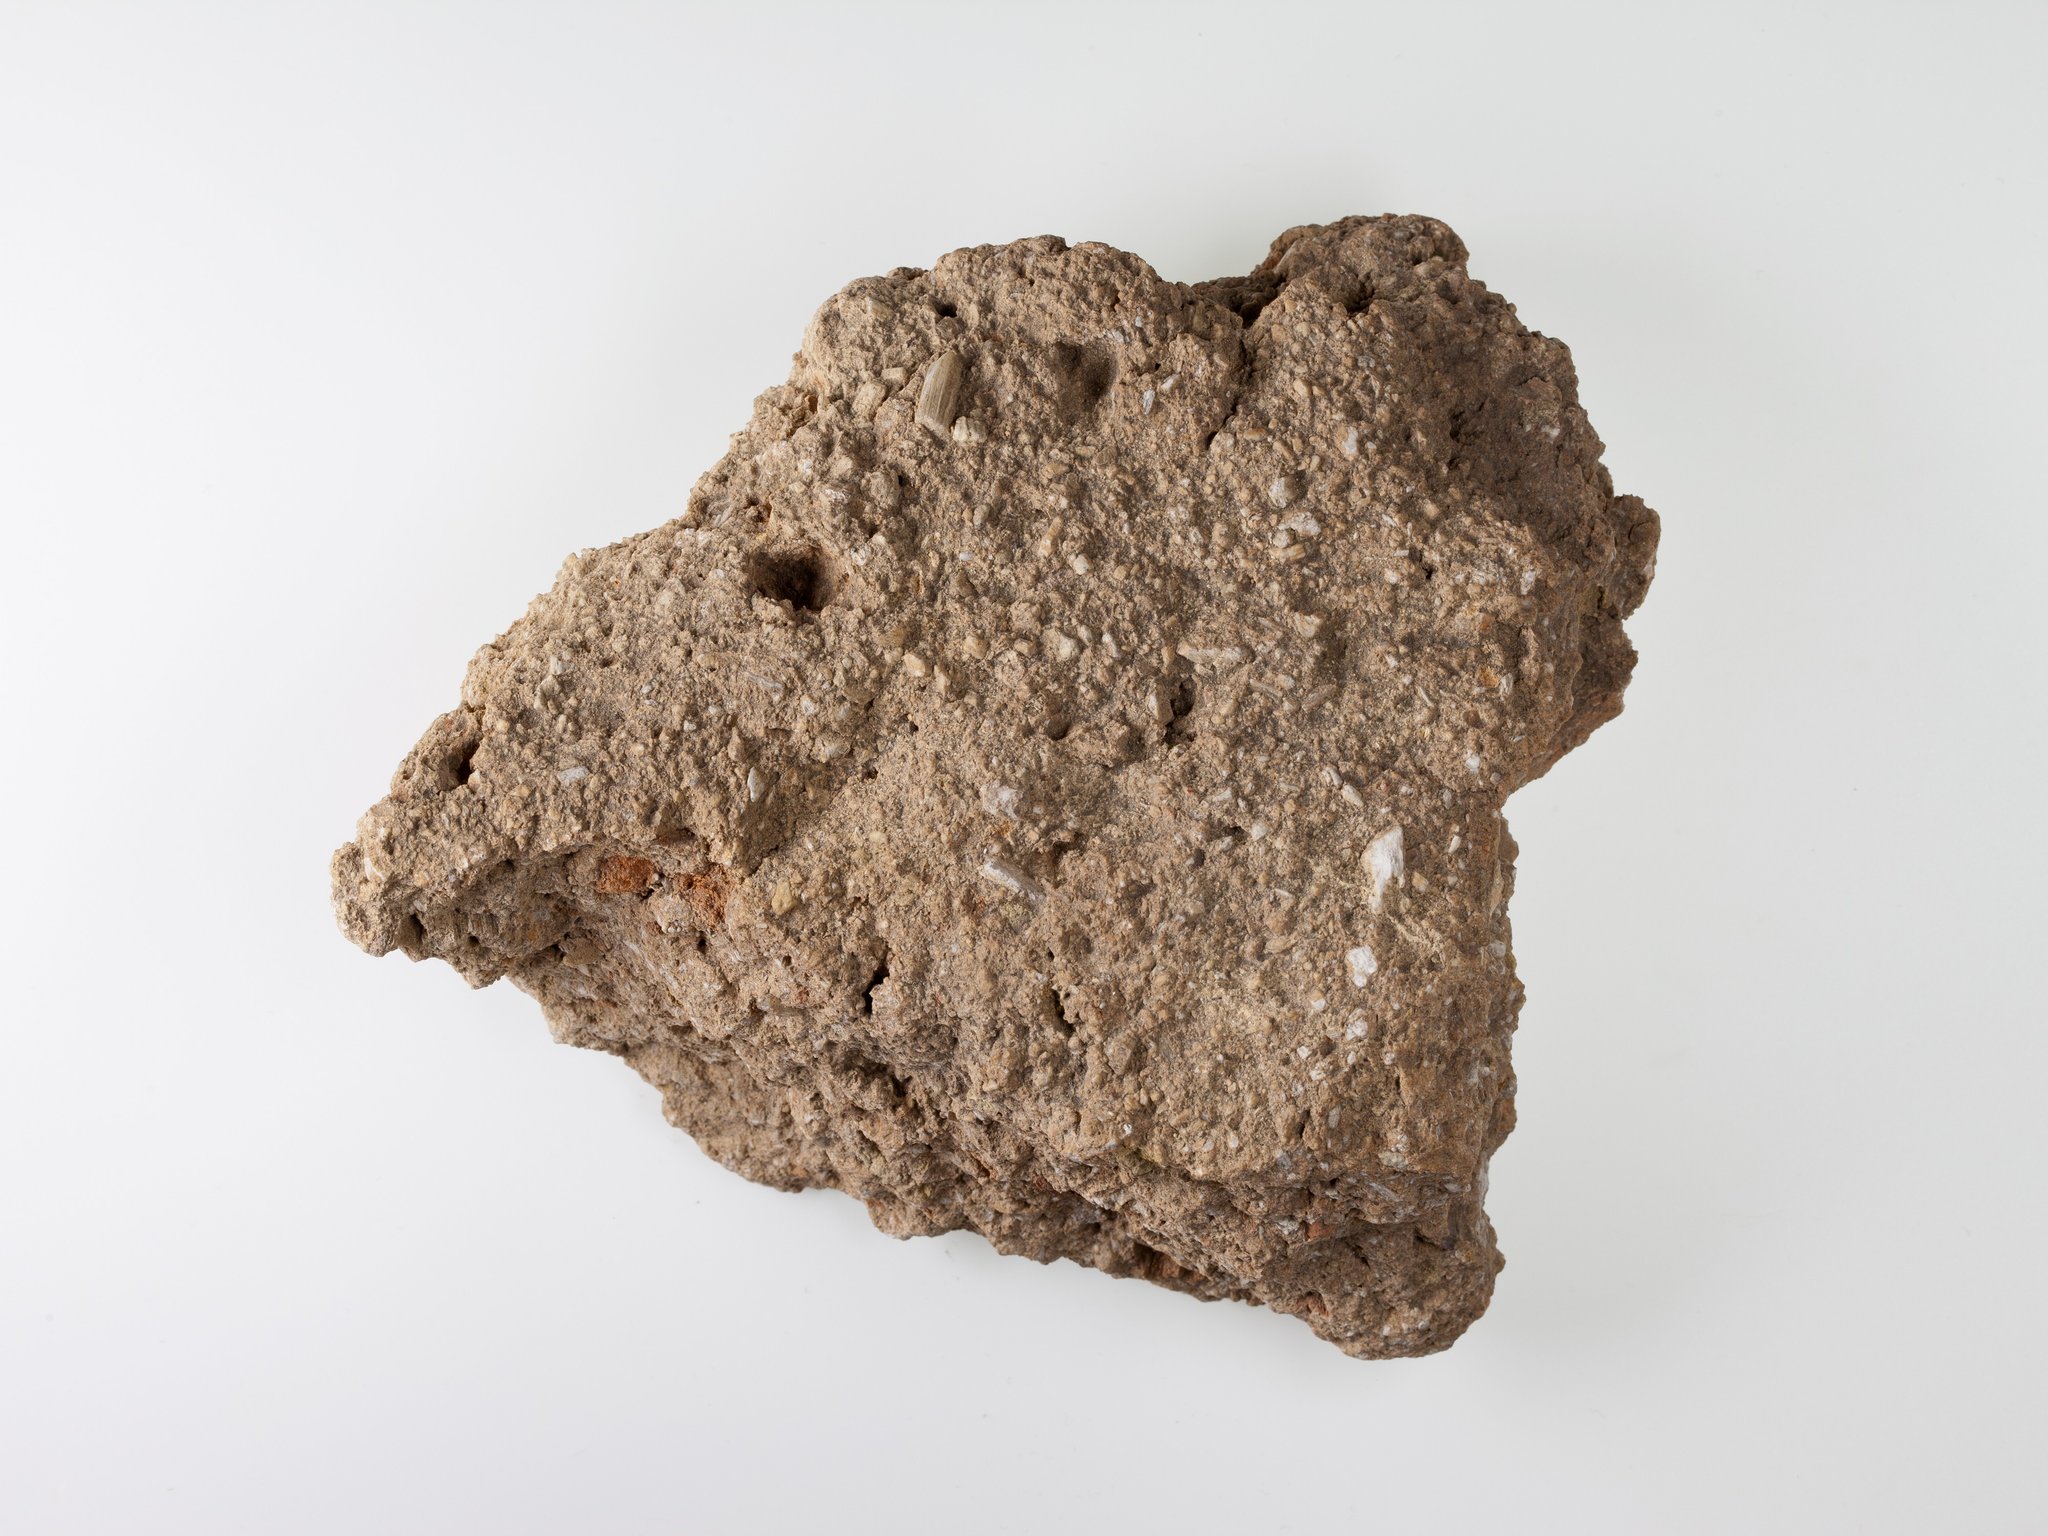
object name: mortar fragment, giza pyramid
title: Specimen of mortar from the Great Pyramid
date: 2551-2528 BCE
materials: mortar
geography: egypt